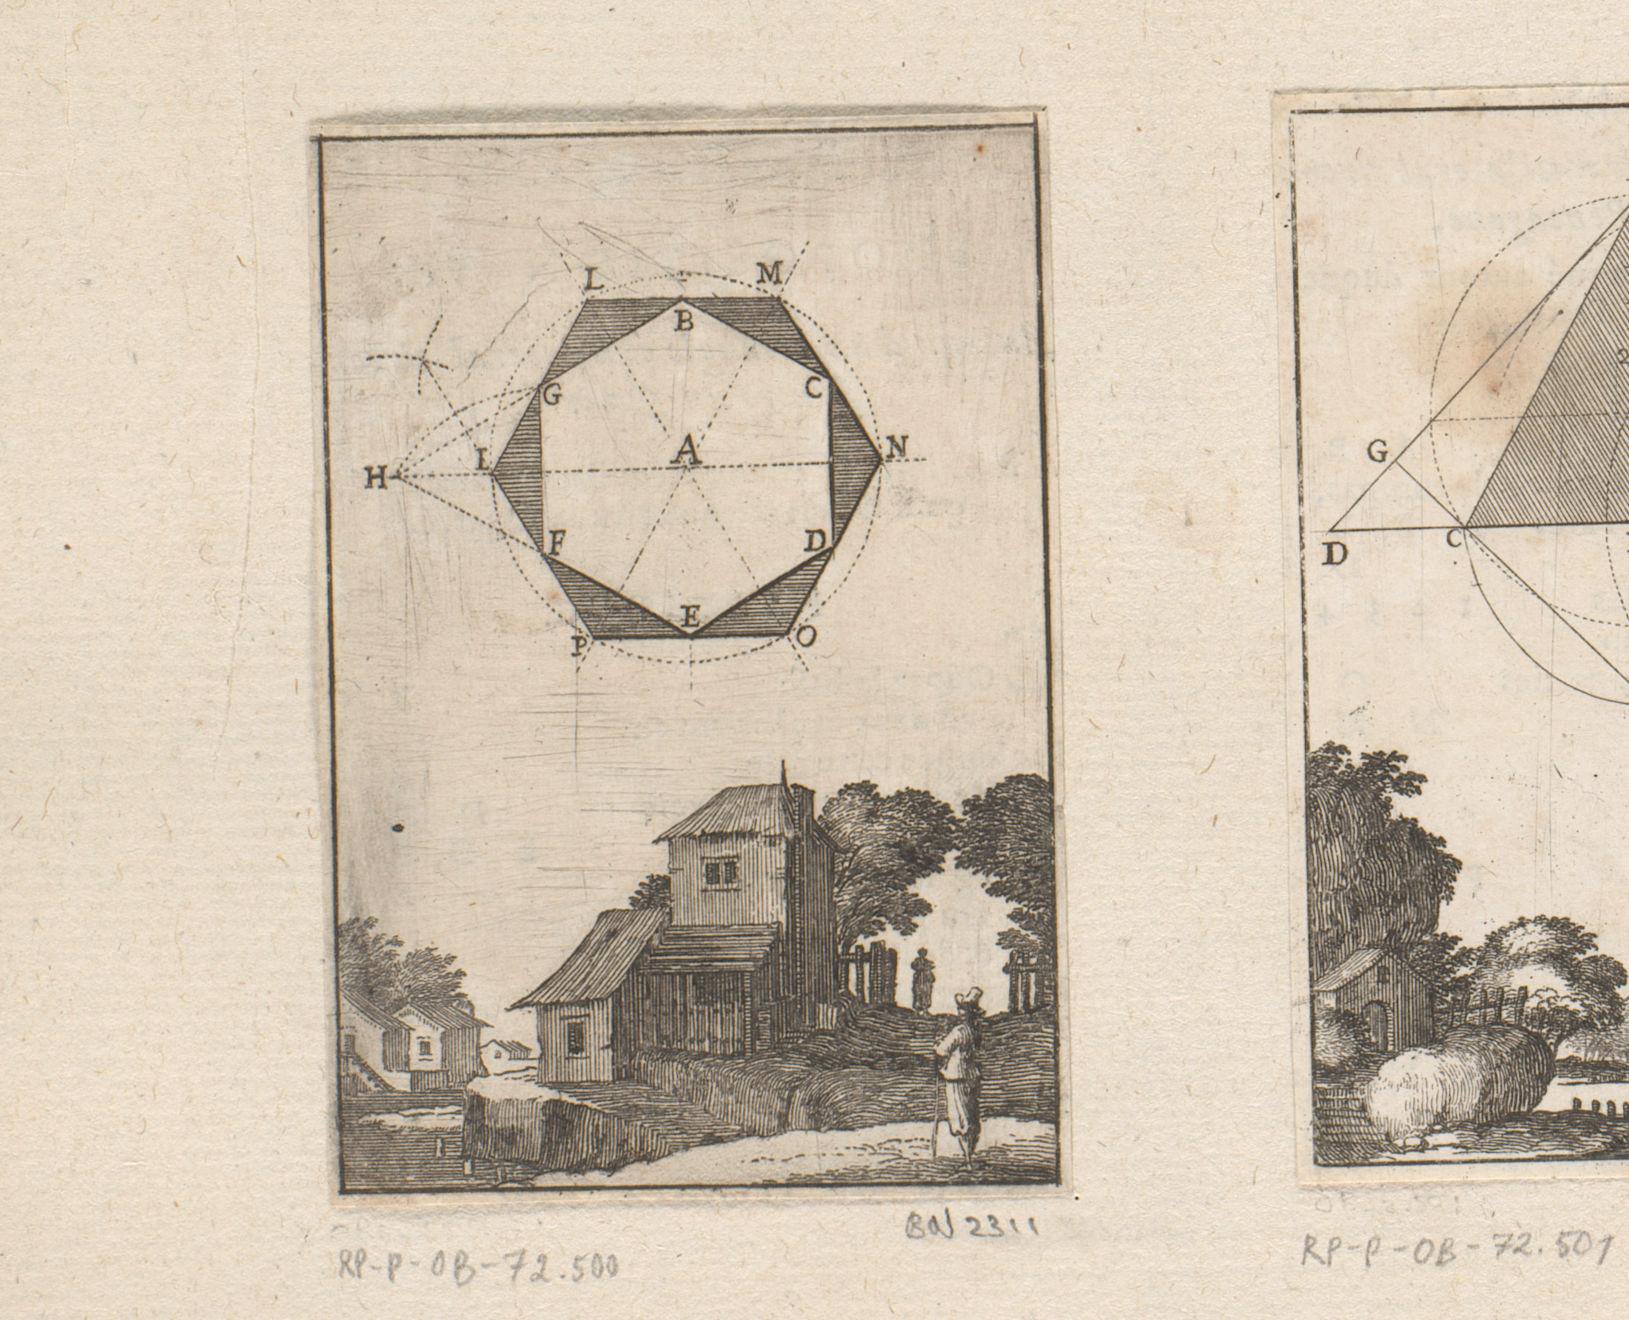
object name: print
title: Gelijkhoekige veelhoek rond een veelhoek met onderaan huizen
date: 1669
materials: paper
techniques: engraving, etching, letterpress printing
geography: paris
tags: adult man, rural housing, e.g. country-house, villa, cottage, planimetry, geometry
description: Prent uit: Pratique de la géometrie, sur le papier et sur le terrain. Avec un nouvel ordre et une méthode particulière. Parijs: Thomas Jolly, 1669.